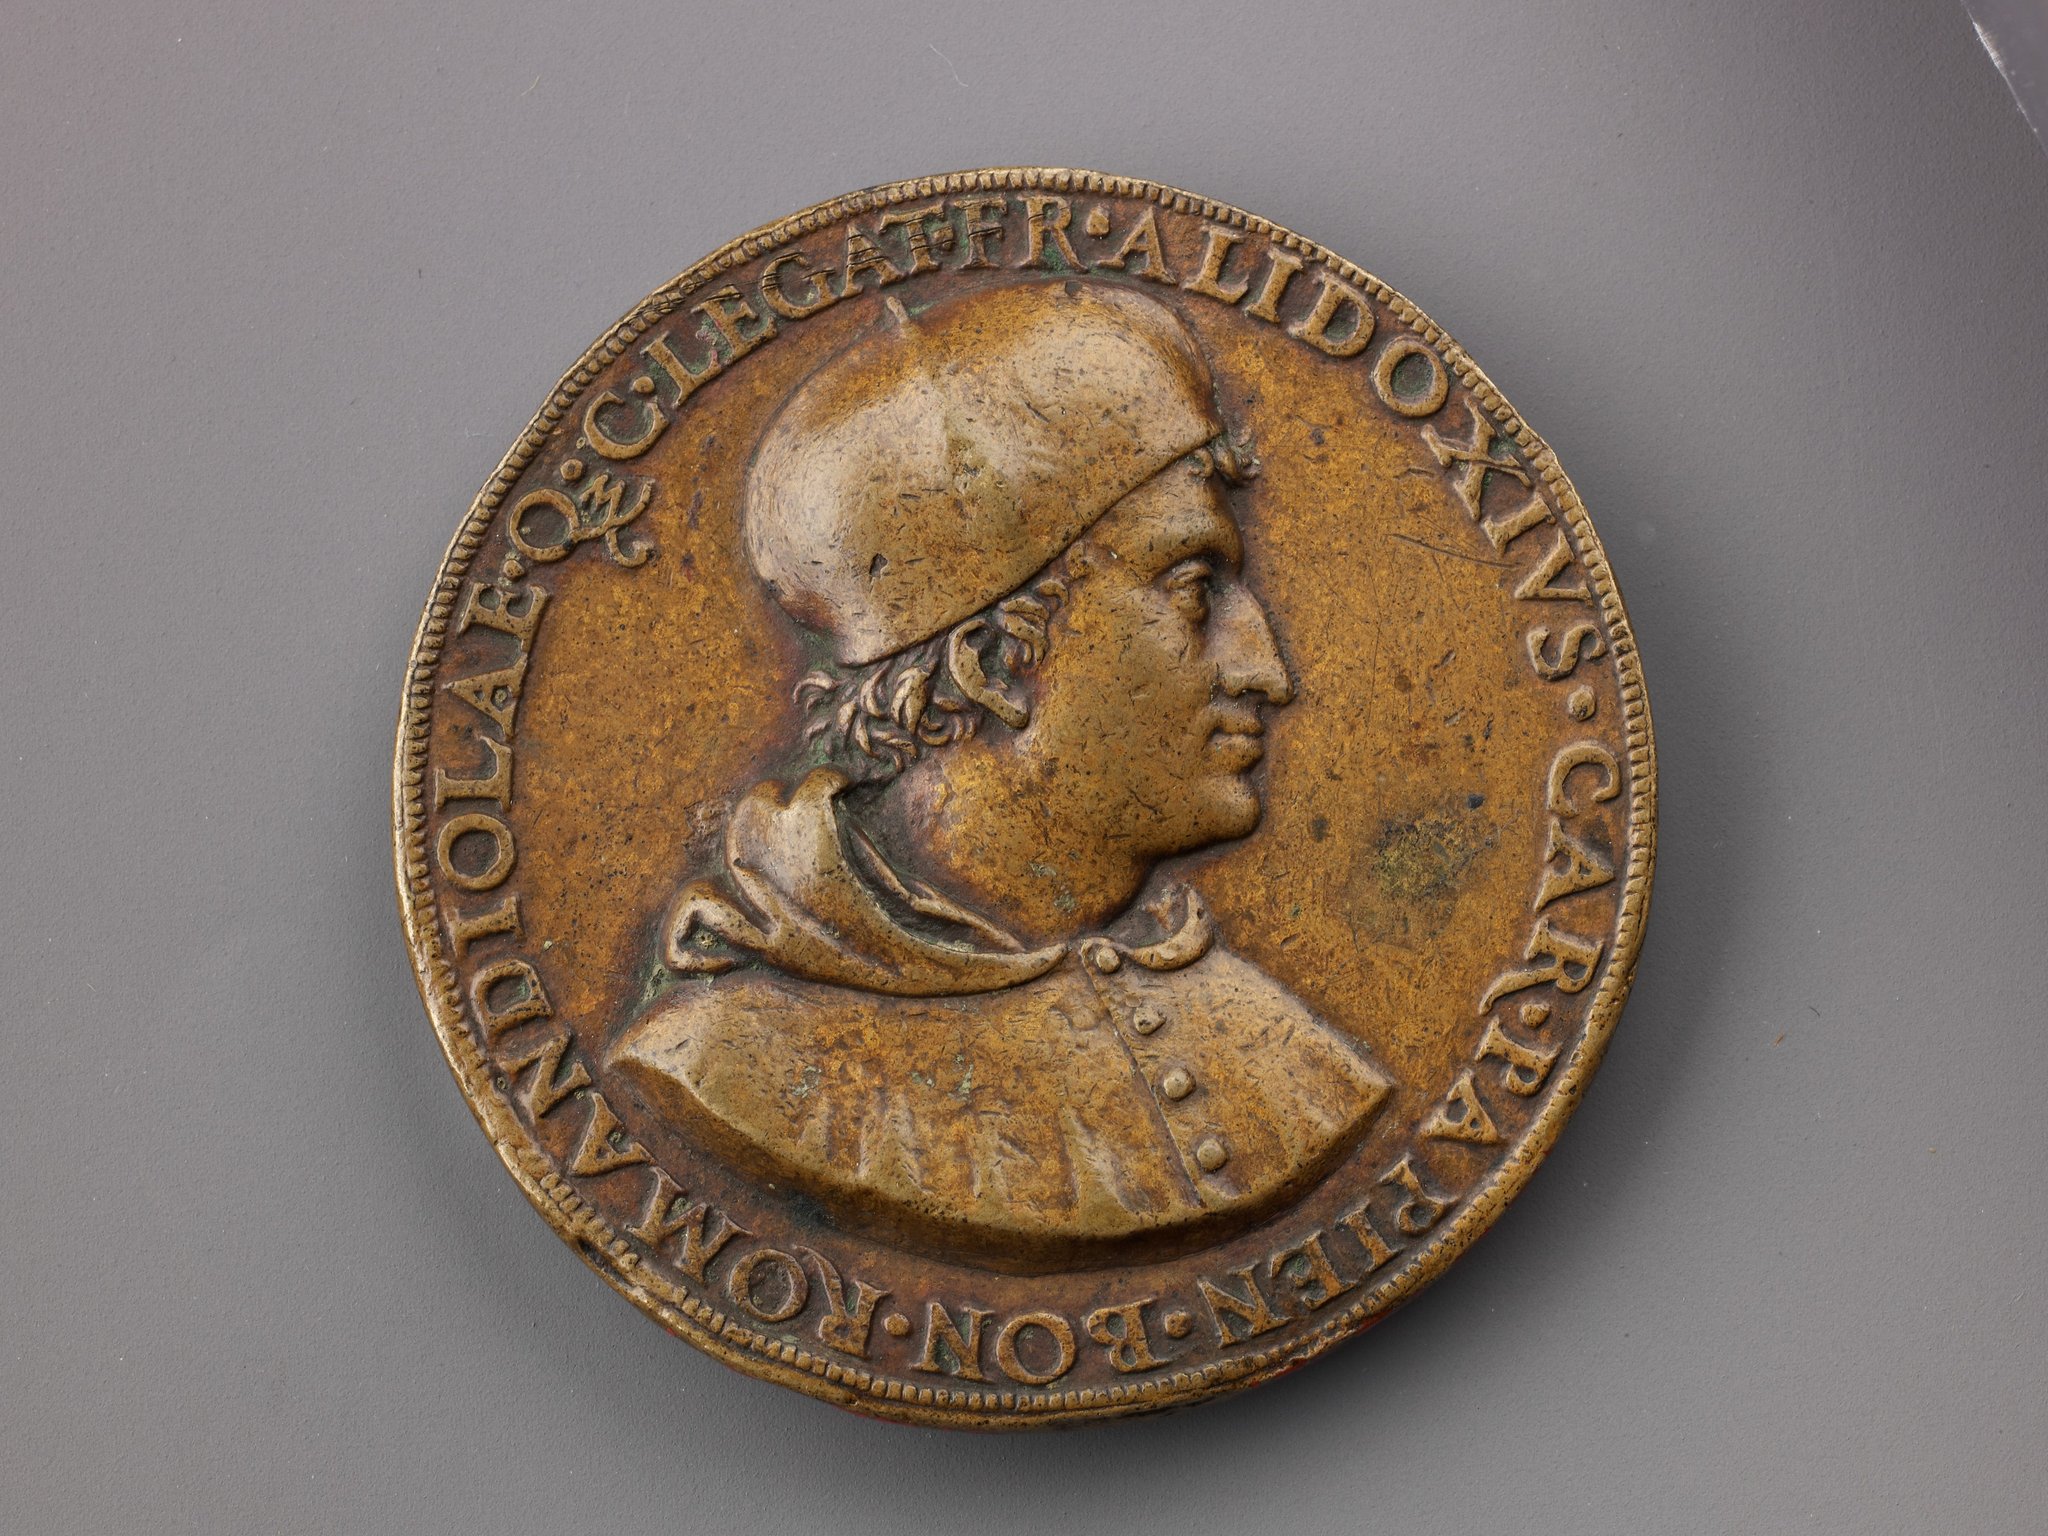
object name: medal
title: Portrait medal of Cardinal Francesco degli Alidosi (obverse); Jupiter and Signs of the Zodiac (reverse)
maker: francesco francia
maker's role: artist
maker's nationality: italian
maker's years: 1447-1517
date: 1505-1510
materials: bronze, copper alloy, patina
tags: eagles,men,profiles,jupiter,zodiac